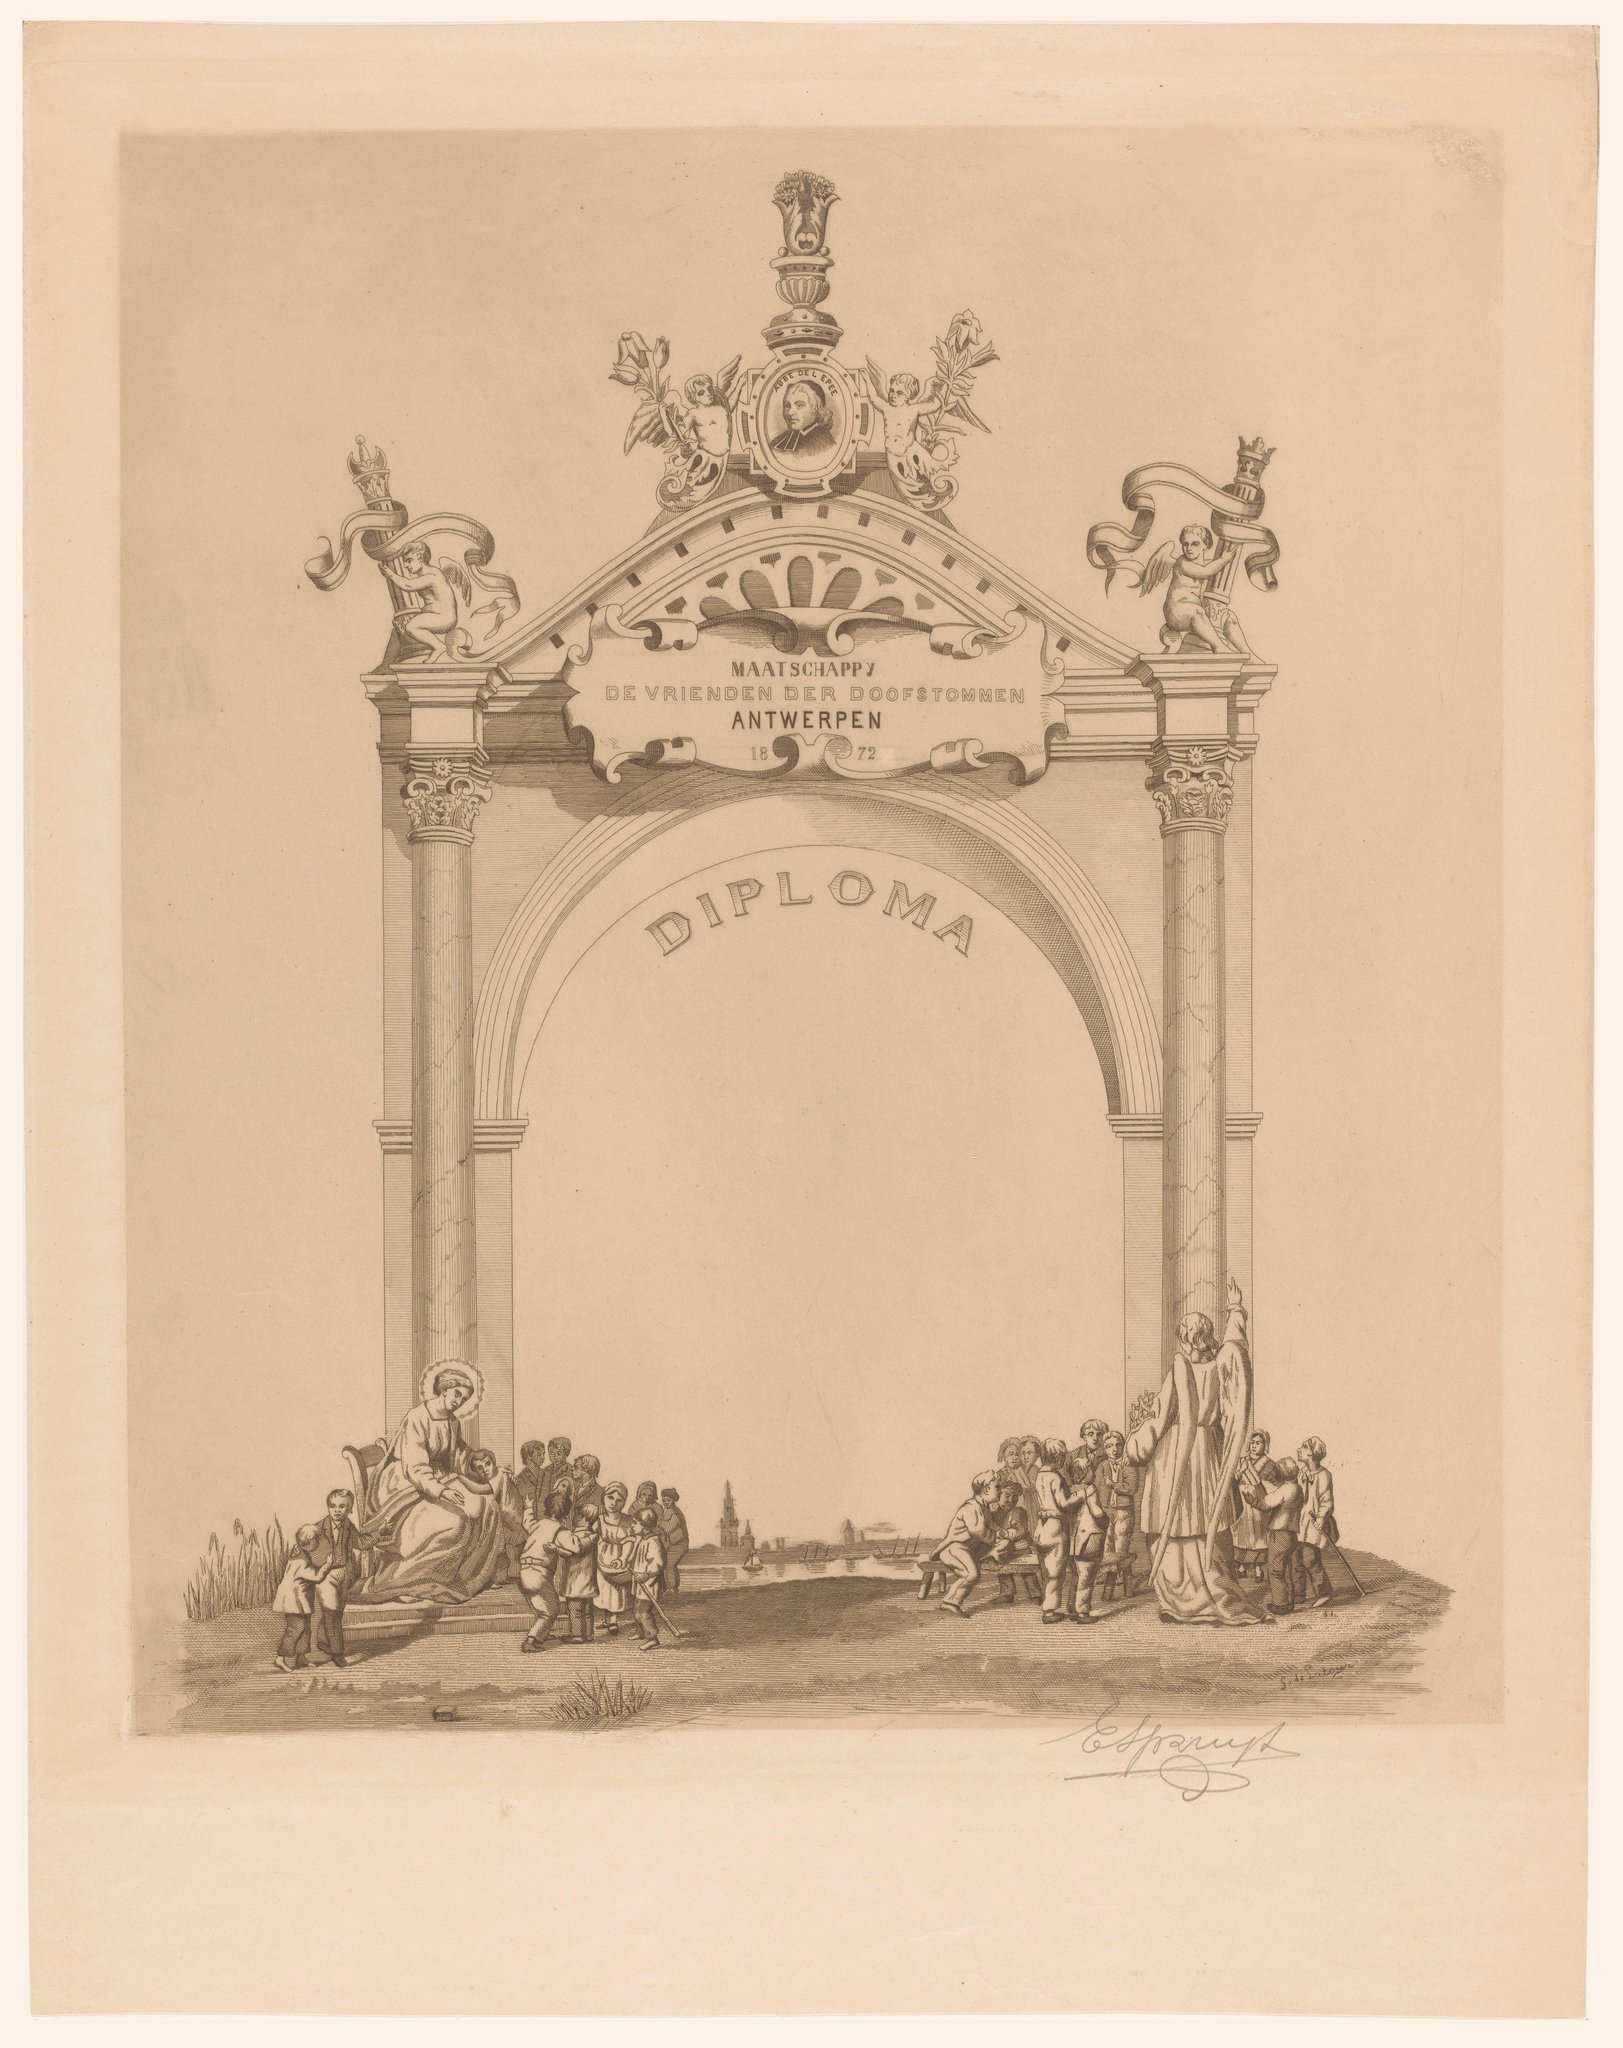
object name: print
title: Diploma van Maatschappij de Vrienden der Doofstommen te Antwerpen met bovenaan een portret van Charles Michel de l'Epee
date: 1872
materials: paper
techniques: etching, intaglio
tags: deaf, deafness, historical persons, ideal and visionary architecture, antwerp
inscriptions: collector's mark: Lugt 2228